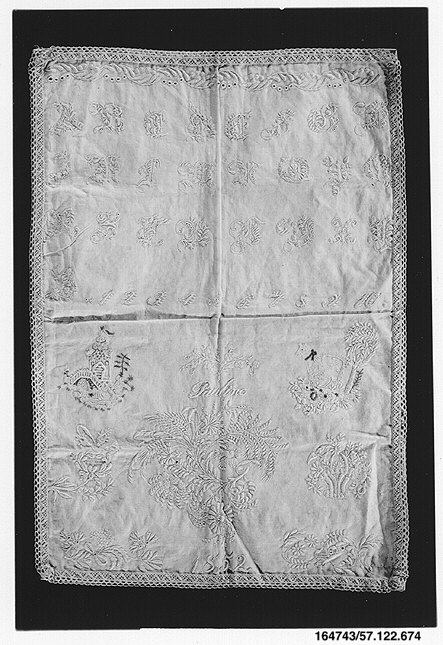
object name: sampler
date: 1852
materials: cotton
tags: flowers